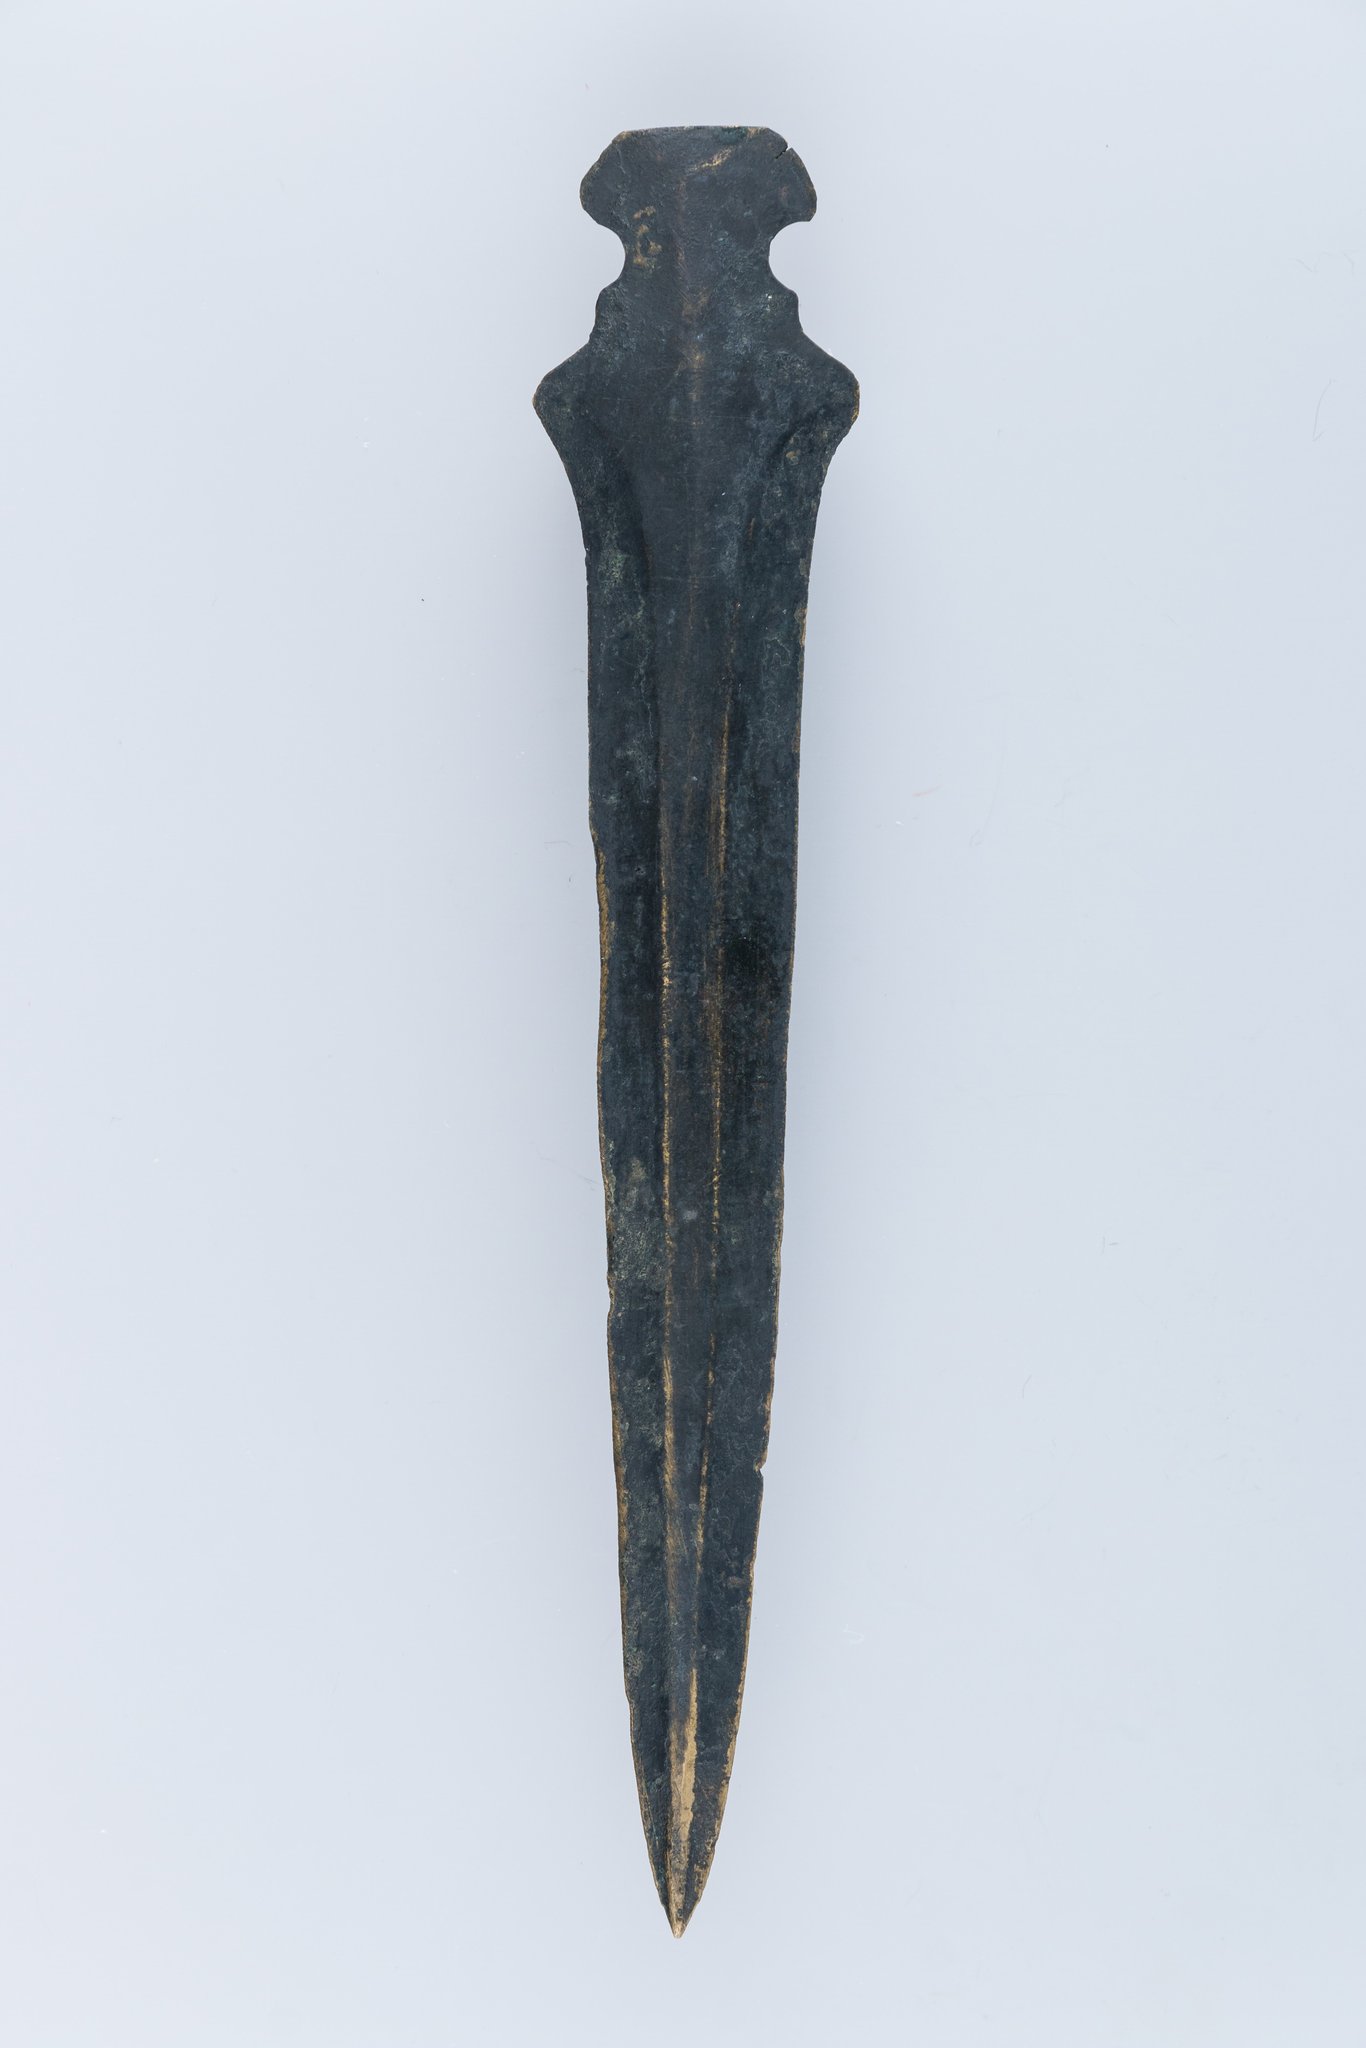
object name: dagger dirk blade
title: Dagger (Dirk) Blade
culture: irish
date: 1500-1200 BCE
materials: bronze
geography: ireland